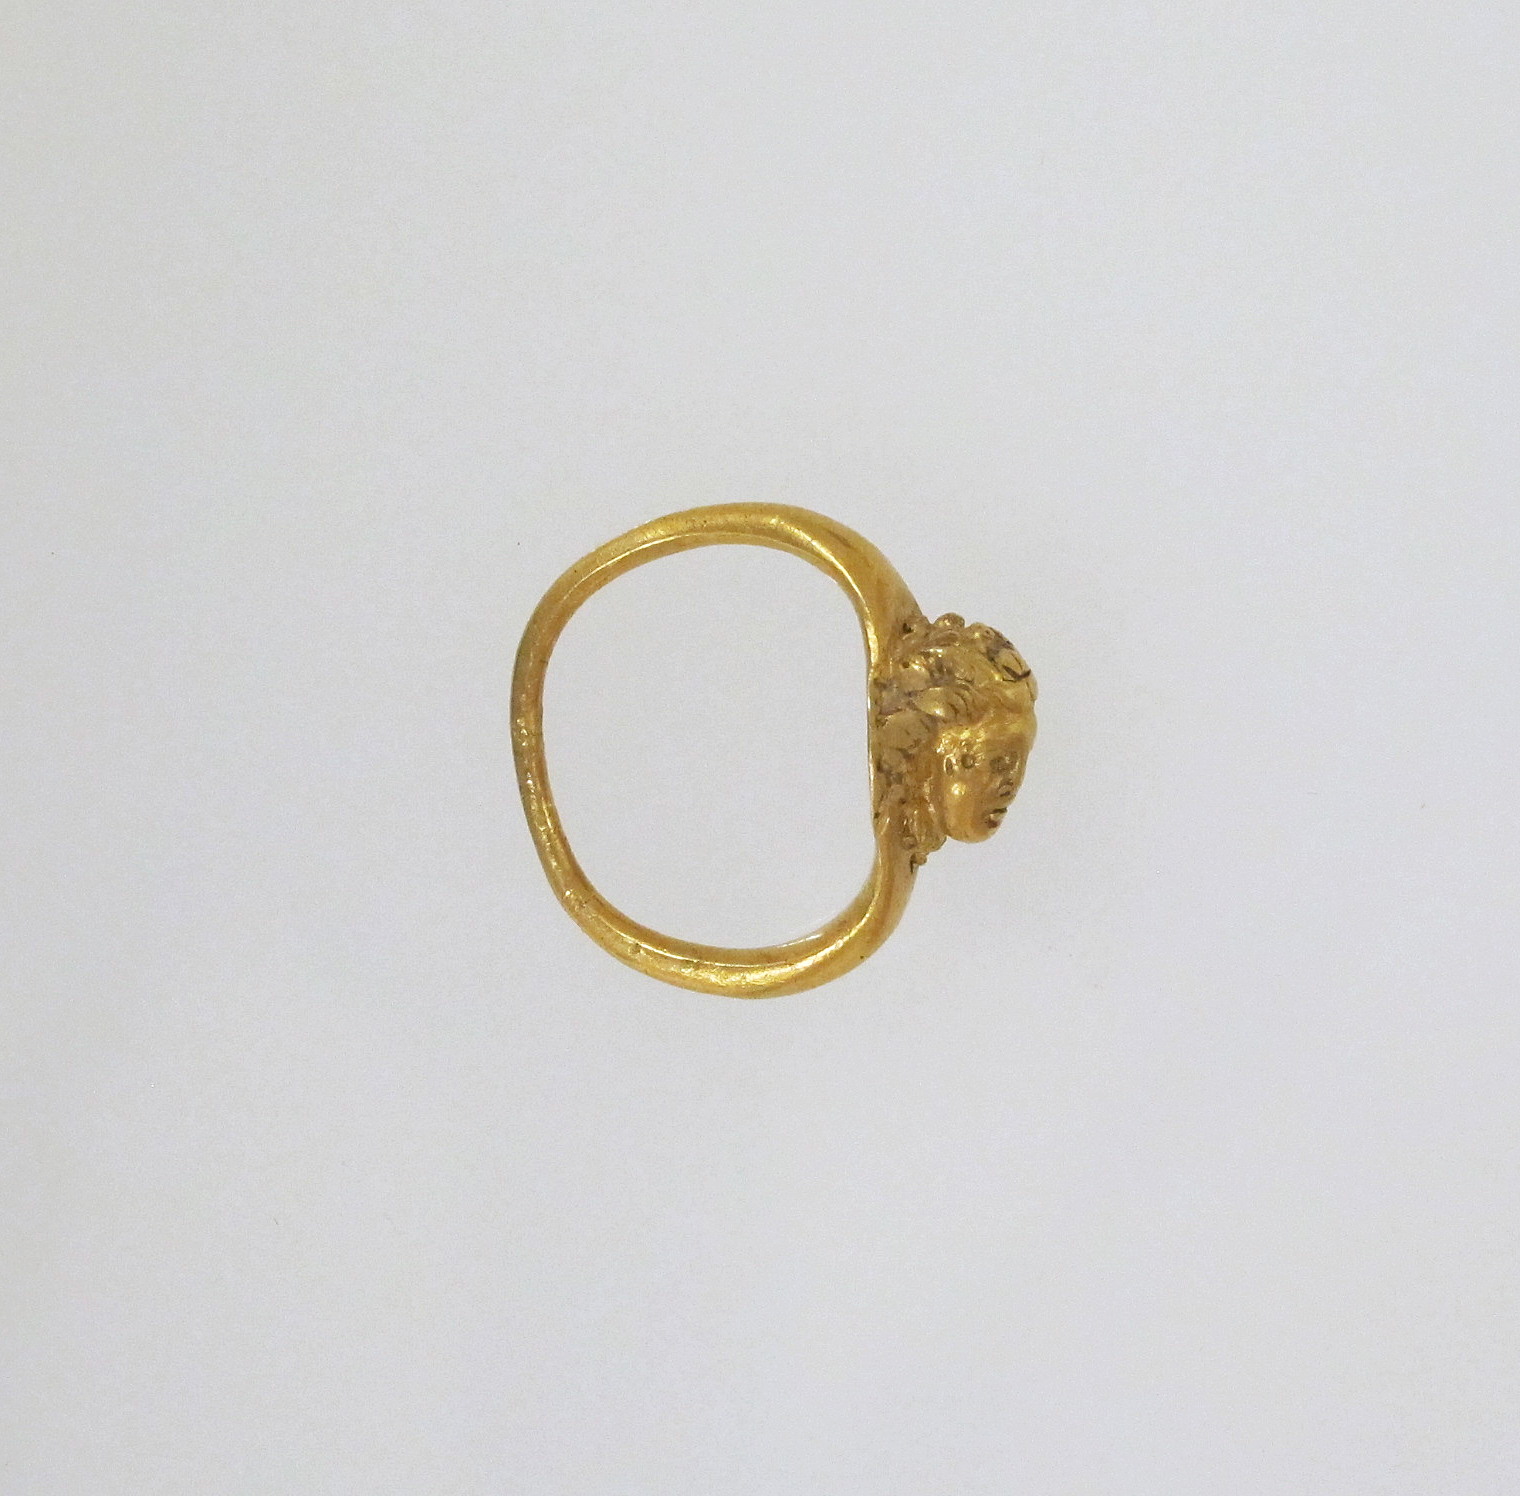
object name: ring with head of a fauness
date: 7000 BCE-330 CE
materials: gold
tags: fauns